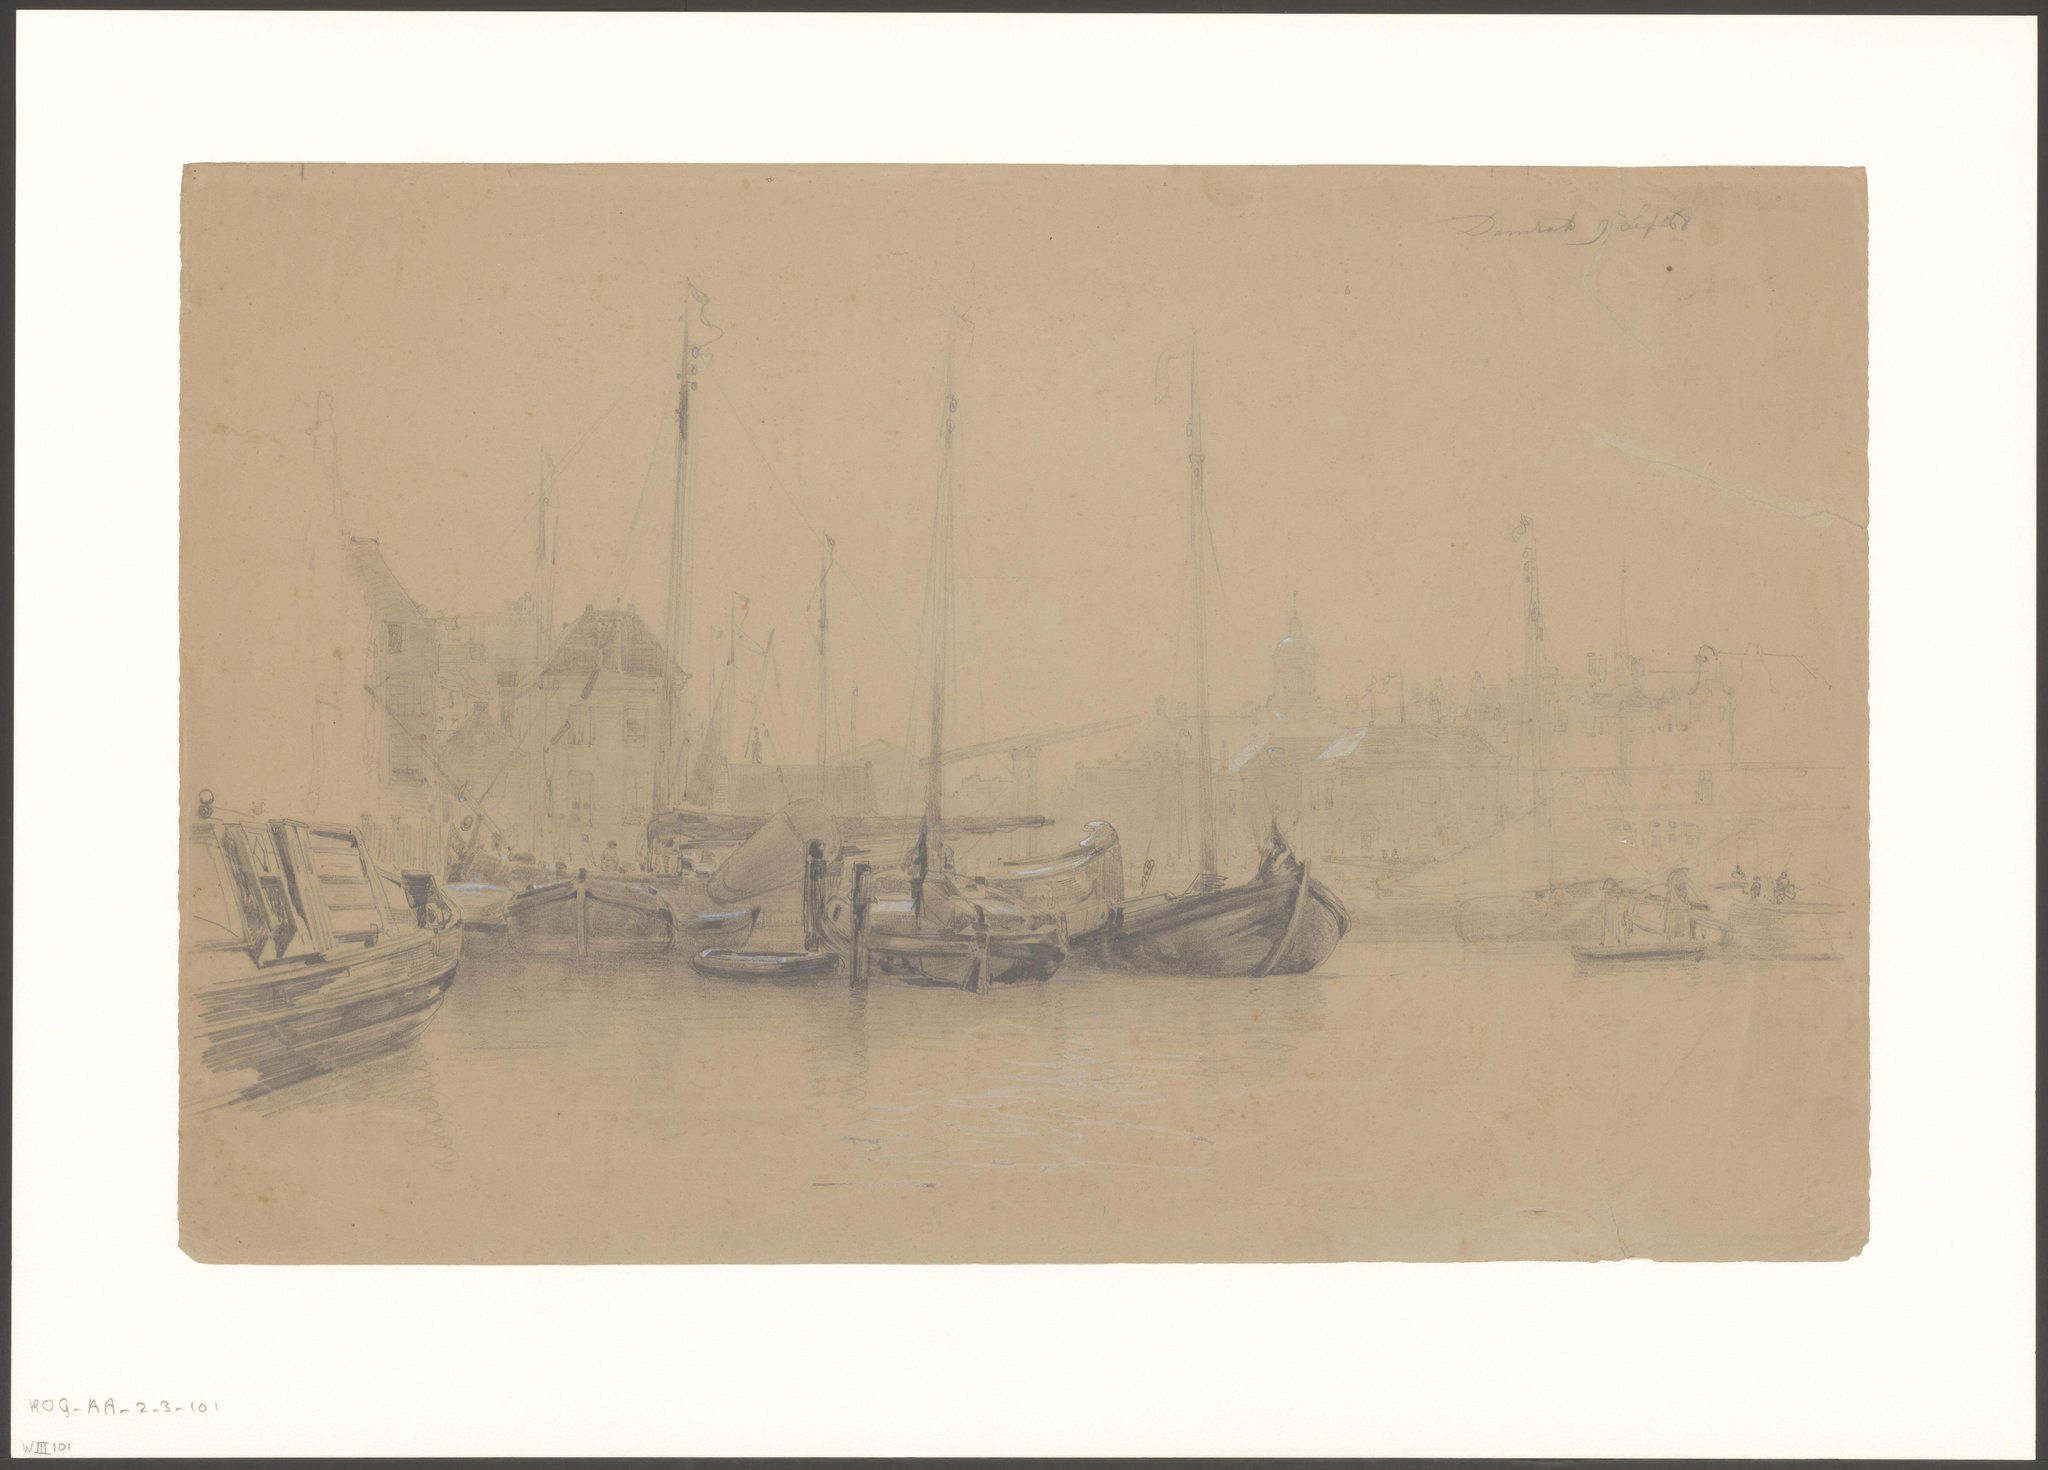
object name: drawing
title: Gezicht op het Damrak gezien naar de Oude Brug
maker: johan conrad greive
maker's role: draughtsman, painter, print maker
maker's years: 1837-1891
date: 1868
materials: chalk, paper, pencil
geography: amsterdam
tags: sailing-ship, sailing-boat, city-view in general; 'veduta', canal, bridge in city across river, canal, etc.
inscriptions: date: ‘Damrak 9 Sept 1868’, collector's mark: Lugt 800a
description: Tekening binnen de Atlas Van Eck ingedeeld op wijknummer 3.